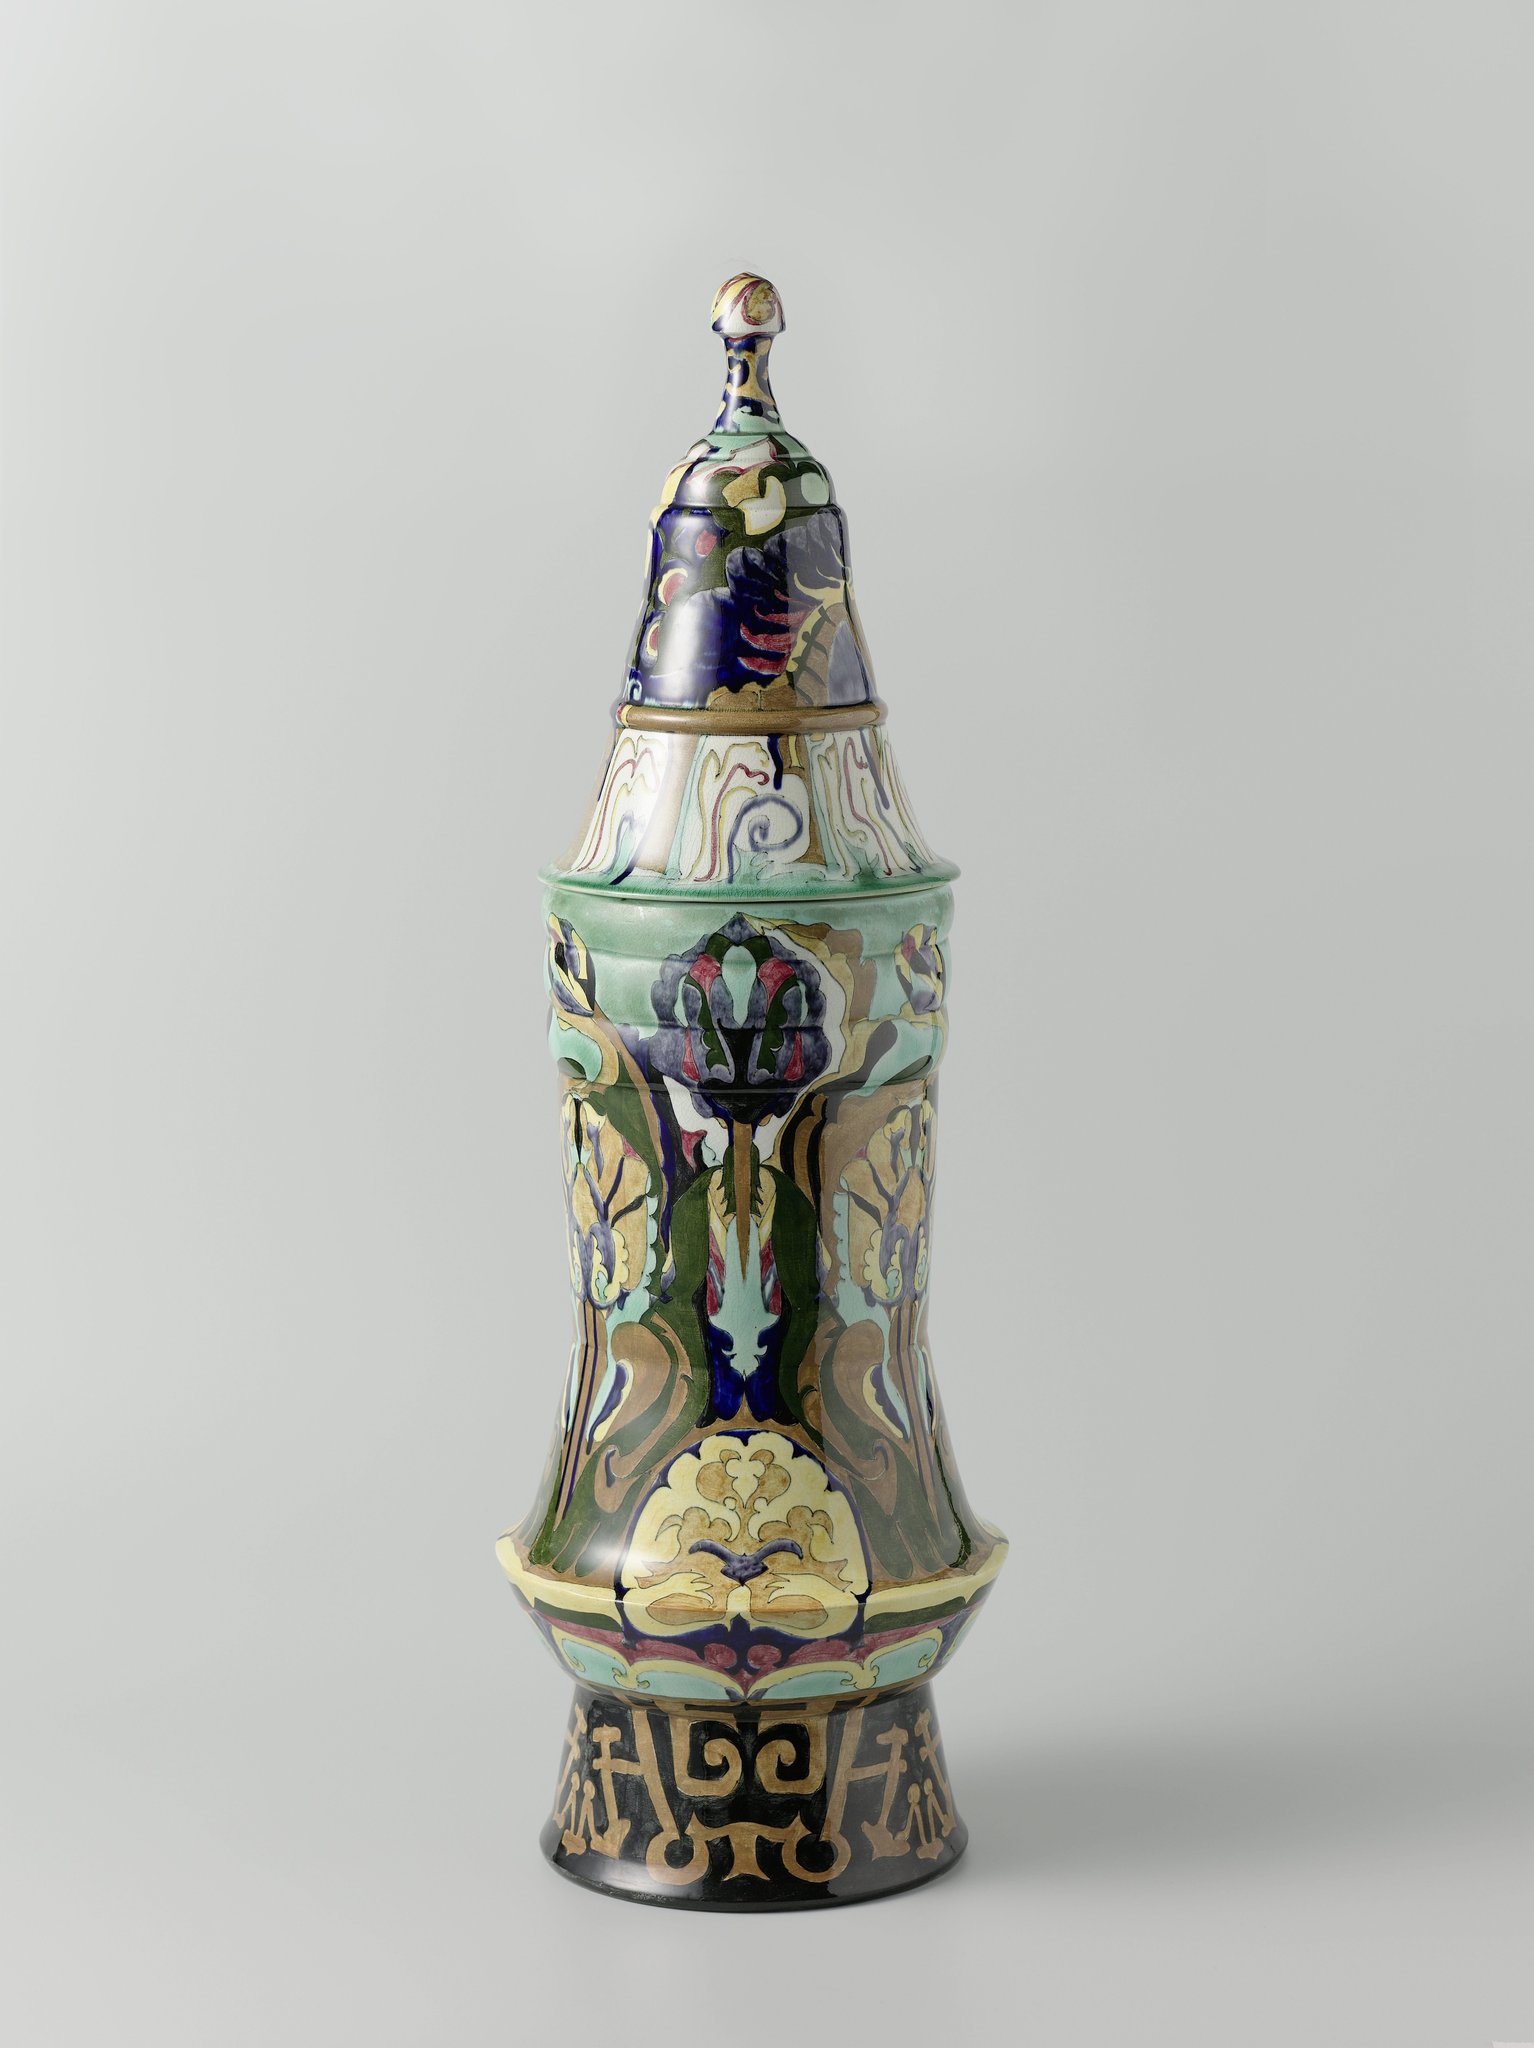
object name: vase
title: Garniture of five vases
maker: theo colenbrander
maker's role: draughtsman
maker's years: 1841-1930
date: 1886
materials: earthenware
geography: the hague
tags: flowers ~ ornament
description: Theo Colenbrander was the artistic mastermind of the Rozenburg earthenware factory in The Hague. His designs exhibit great freedom in both form and decoration. The slender, ribbed shape of these vases recalls bamboo. The ornamentation is modern: abstractly rendered floral and plant motifs in bright colours. Their shapes, however, are quite old-fashioned. It is a garniture (set) of five vases for display atop a cabinet.